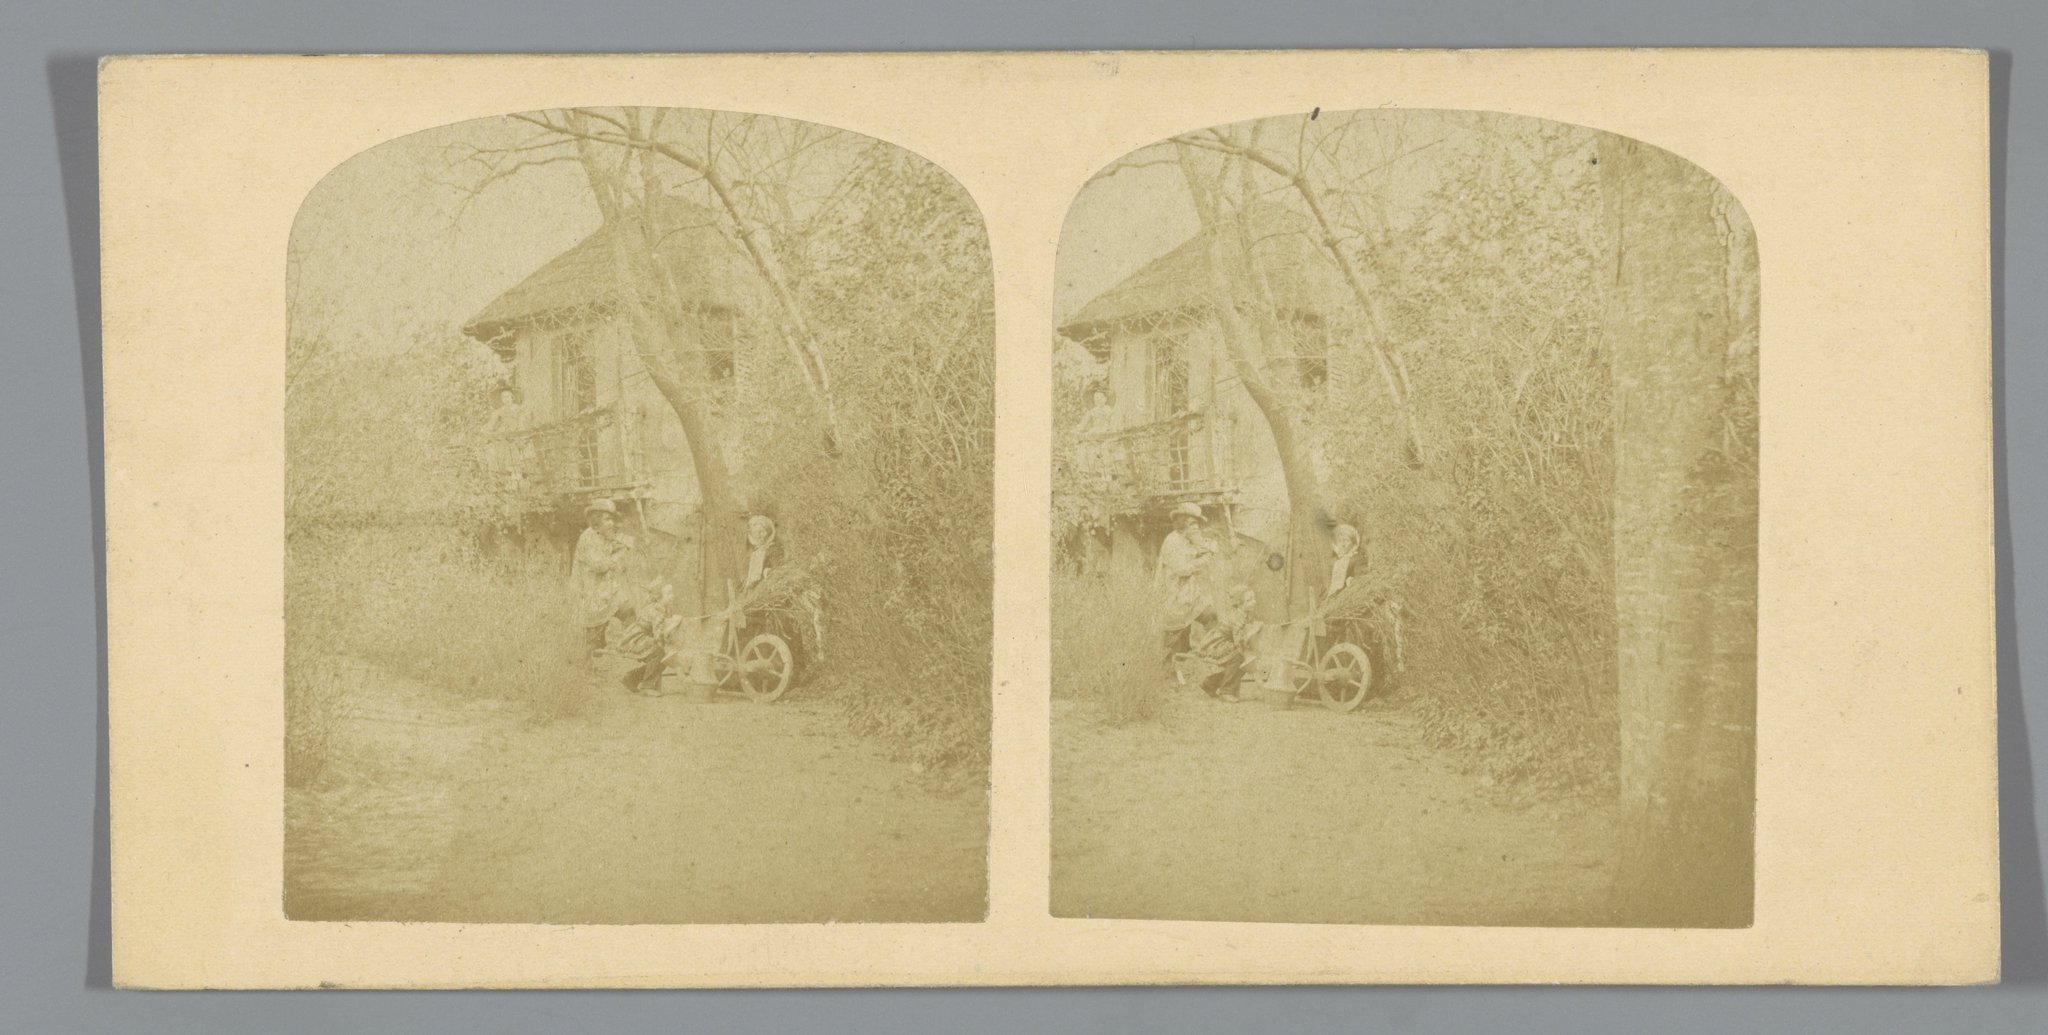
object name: stereograph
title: Man, vrouw en kind, voor een woning in een bosachtige omgeving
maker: Anonymous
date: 1852-1858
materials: cardboard, paper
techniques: albumen print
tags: forest, wood, family life